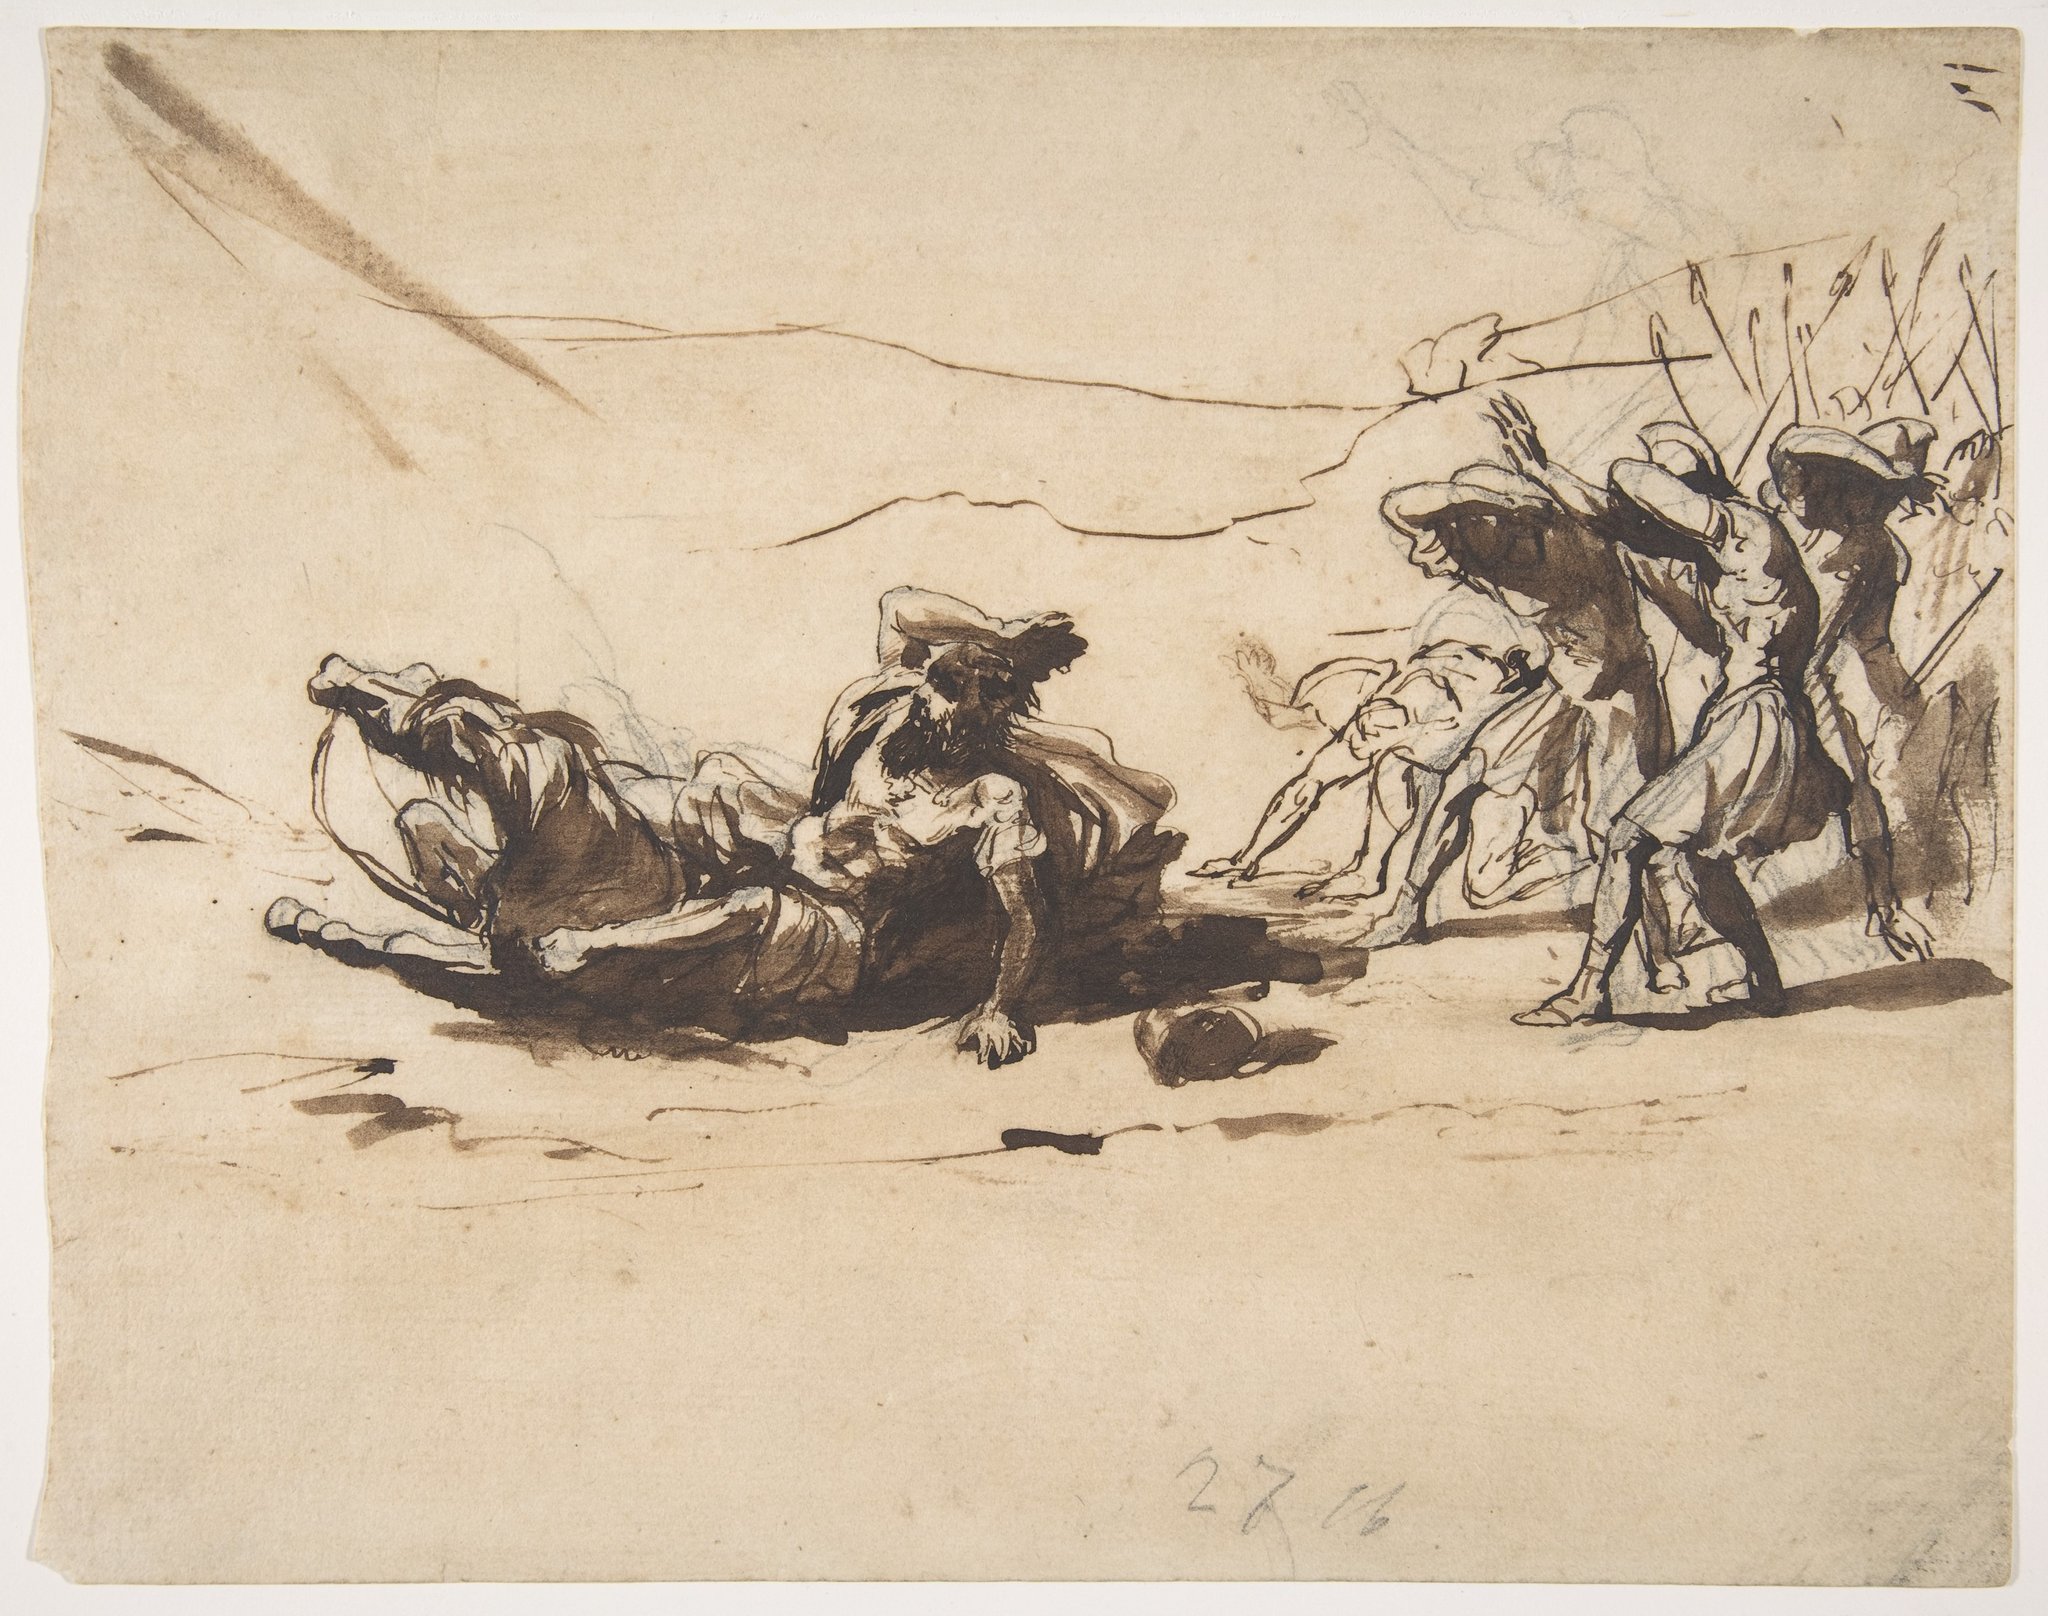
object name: drawing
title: Conversion of Saint Paul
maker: pier francesco mola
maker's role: artist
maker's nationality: italian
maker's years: 1612-1666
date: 1612-1666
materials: chalk, ink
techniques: brush, pen, wash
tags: soldiers,saint paul